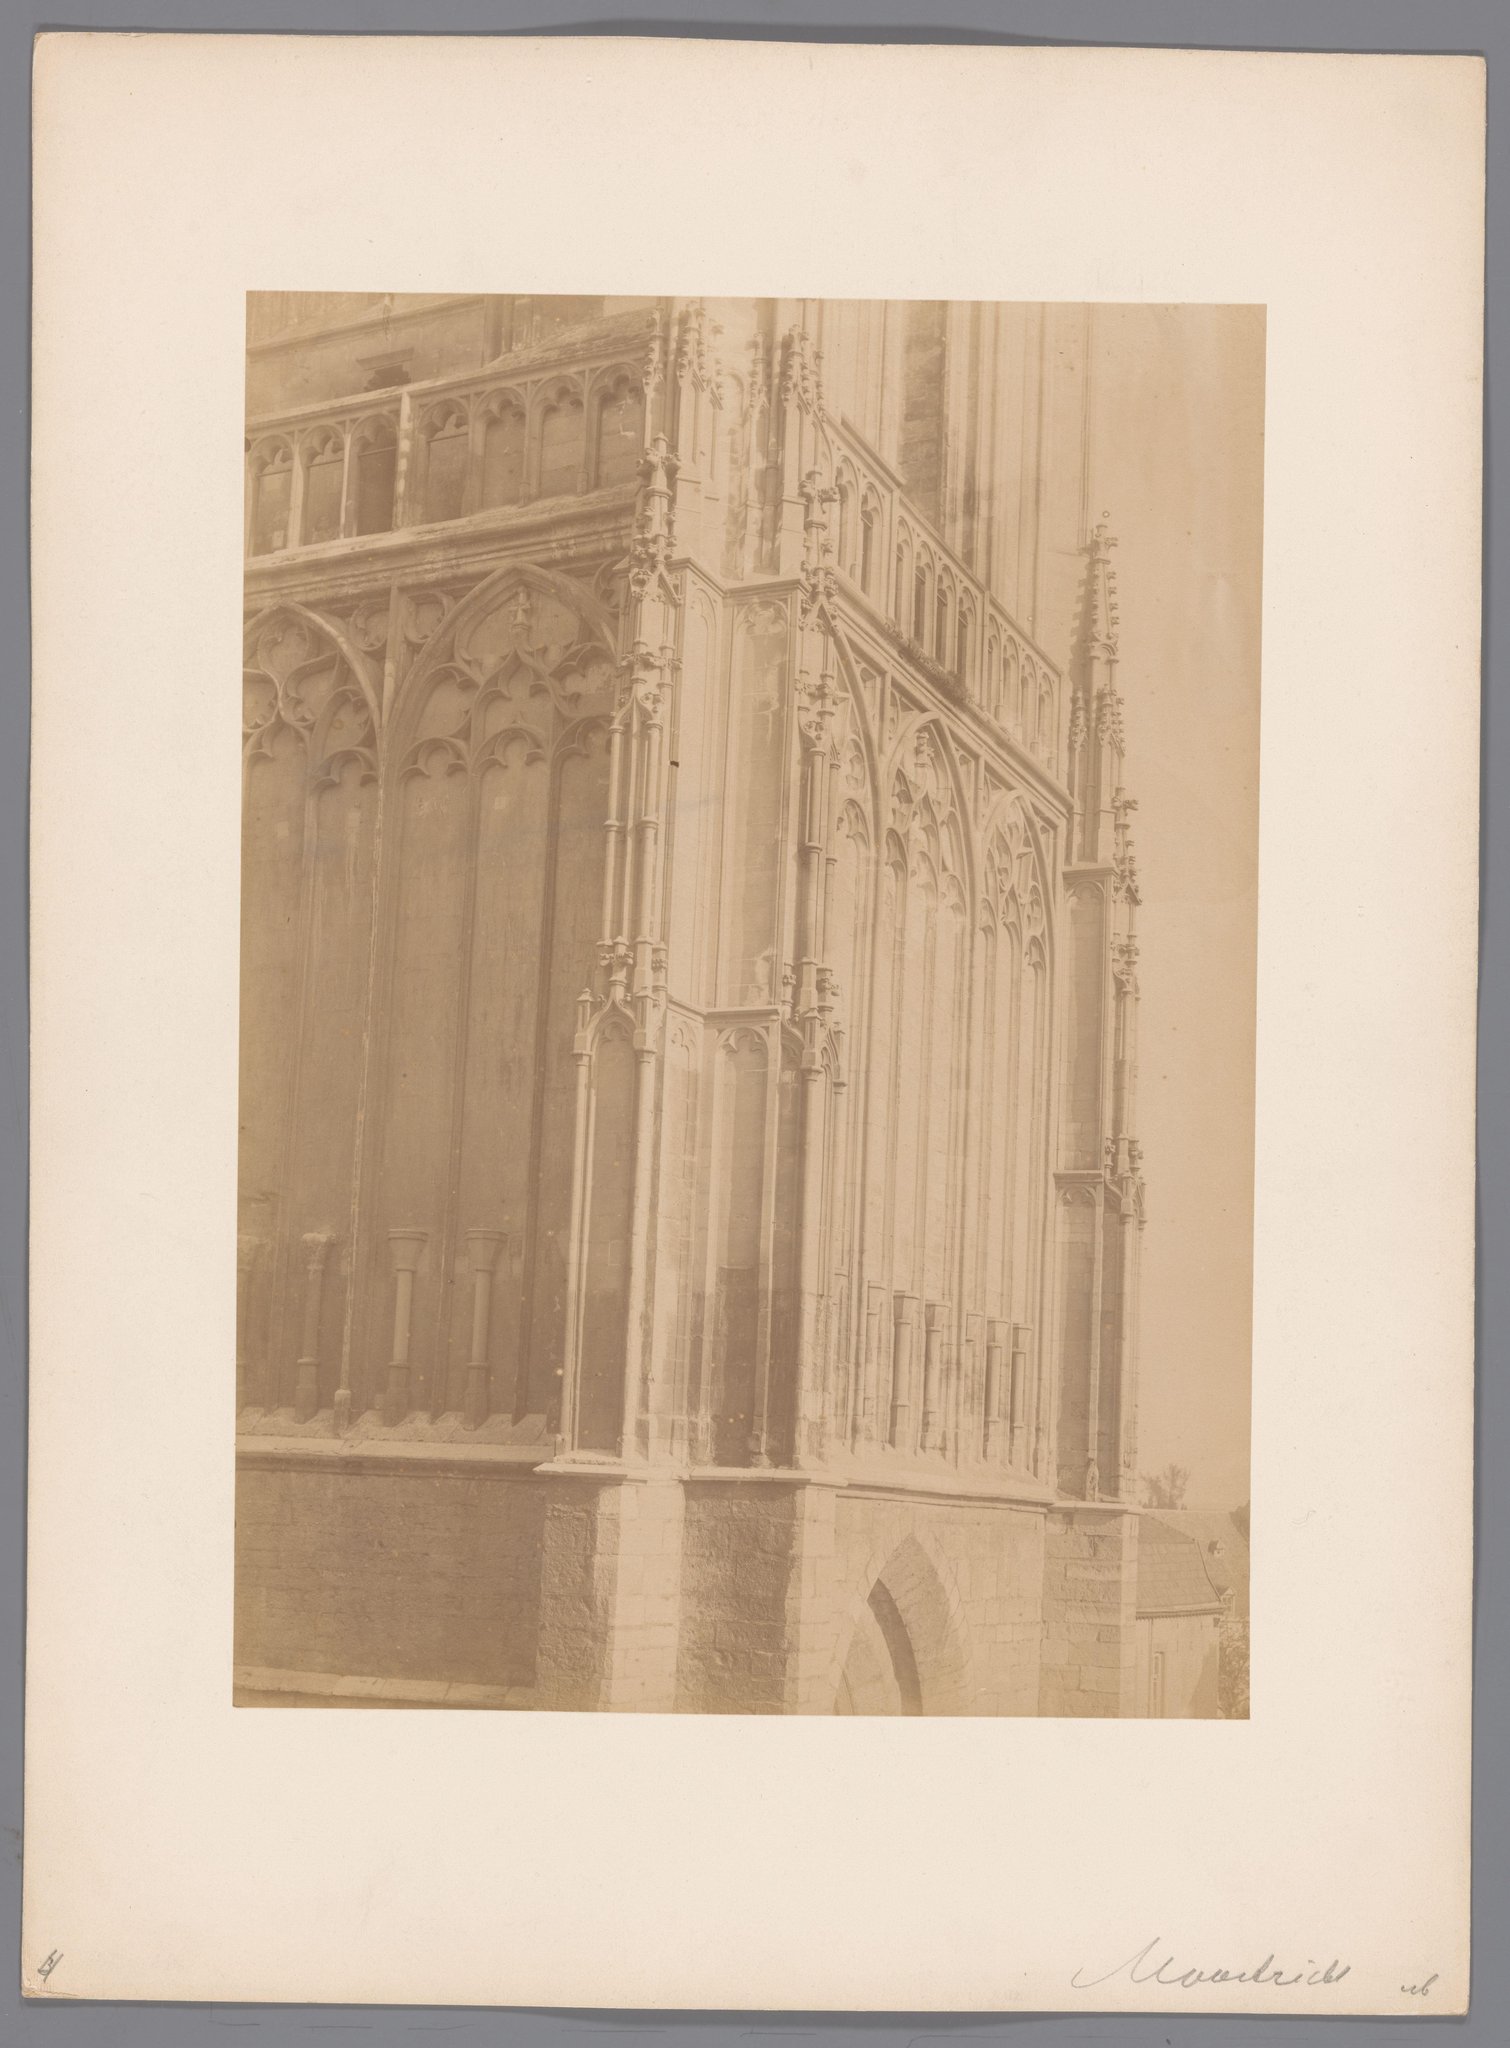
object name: photograph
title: Detail van de toren van de Sint-Janskerk te Maastricht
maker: anoniem (monumentenzorg)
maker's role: fotograaf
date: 1893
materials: cardboard, photographic support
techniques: albumen print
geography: sint-servaasbasiliek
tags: parts of church exterior and annexes: tower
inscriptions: annotation: ‘Maastricht’, annotation: ‘S. Janskerk toren te Maastricht (L.)/ 1ste verdieping (detail)/ Mei 1893’